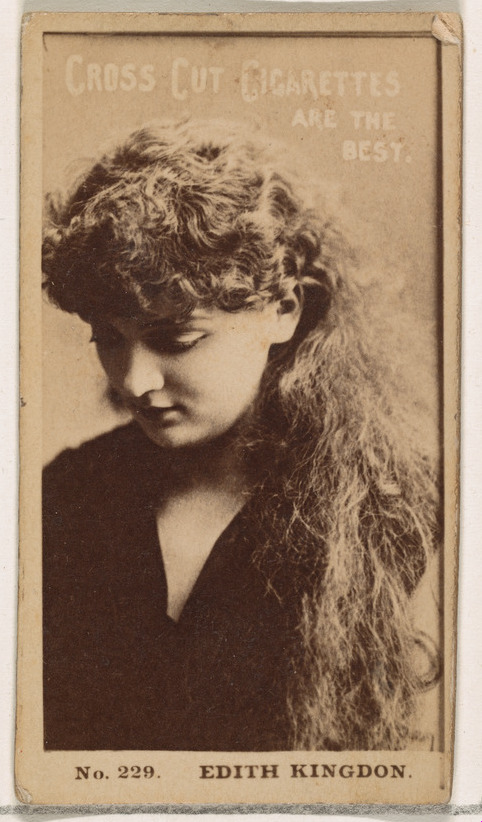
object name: print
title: Card Number 229, Edith Kingdon, from the Actors and Actresses series (N145-2) issued by Duke Sons & Co. to promote Cross Cut Cigarettes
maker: w. duke, sons & co.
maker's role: publisher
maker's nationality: american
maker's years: 1870-1920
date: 1880-1889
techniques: albumen silver print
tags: portraits,women,actresses